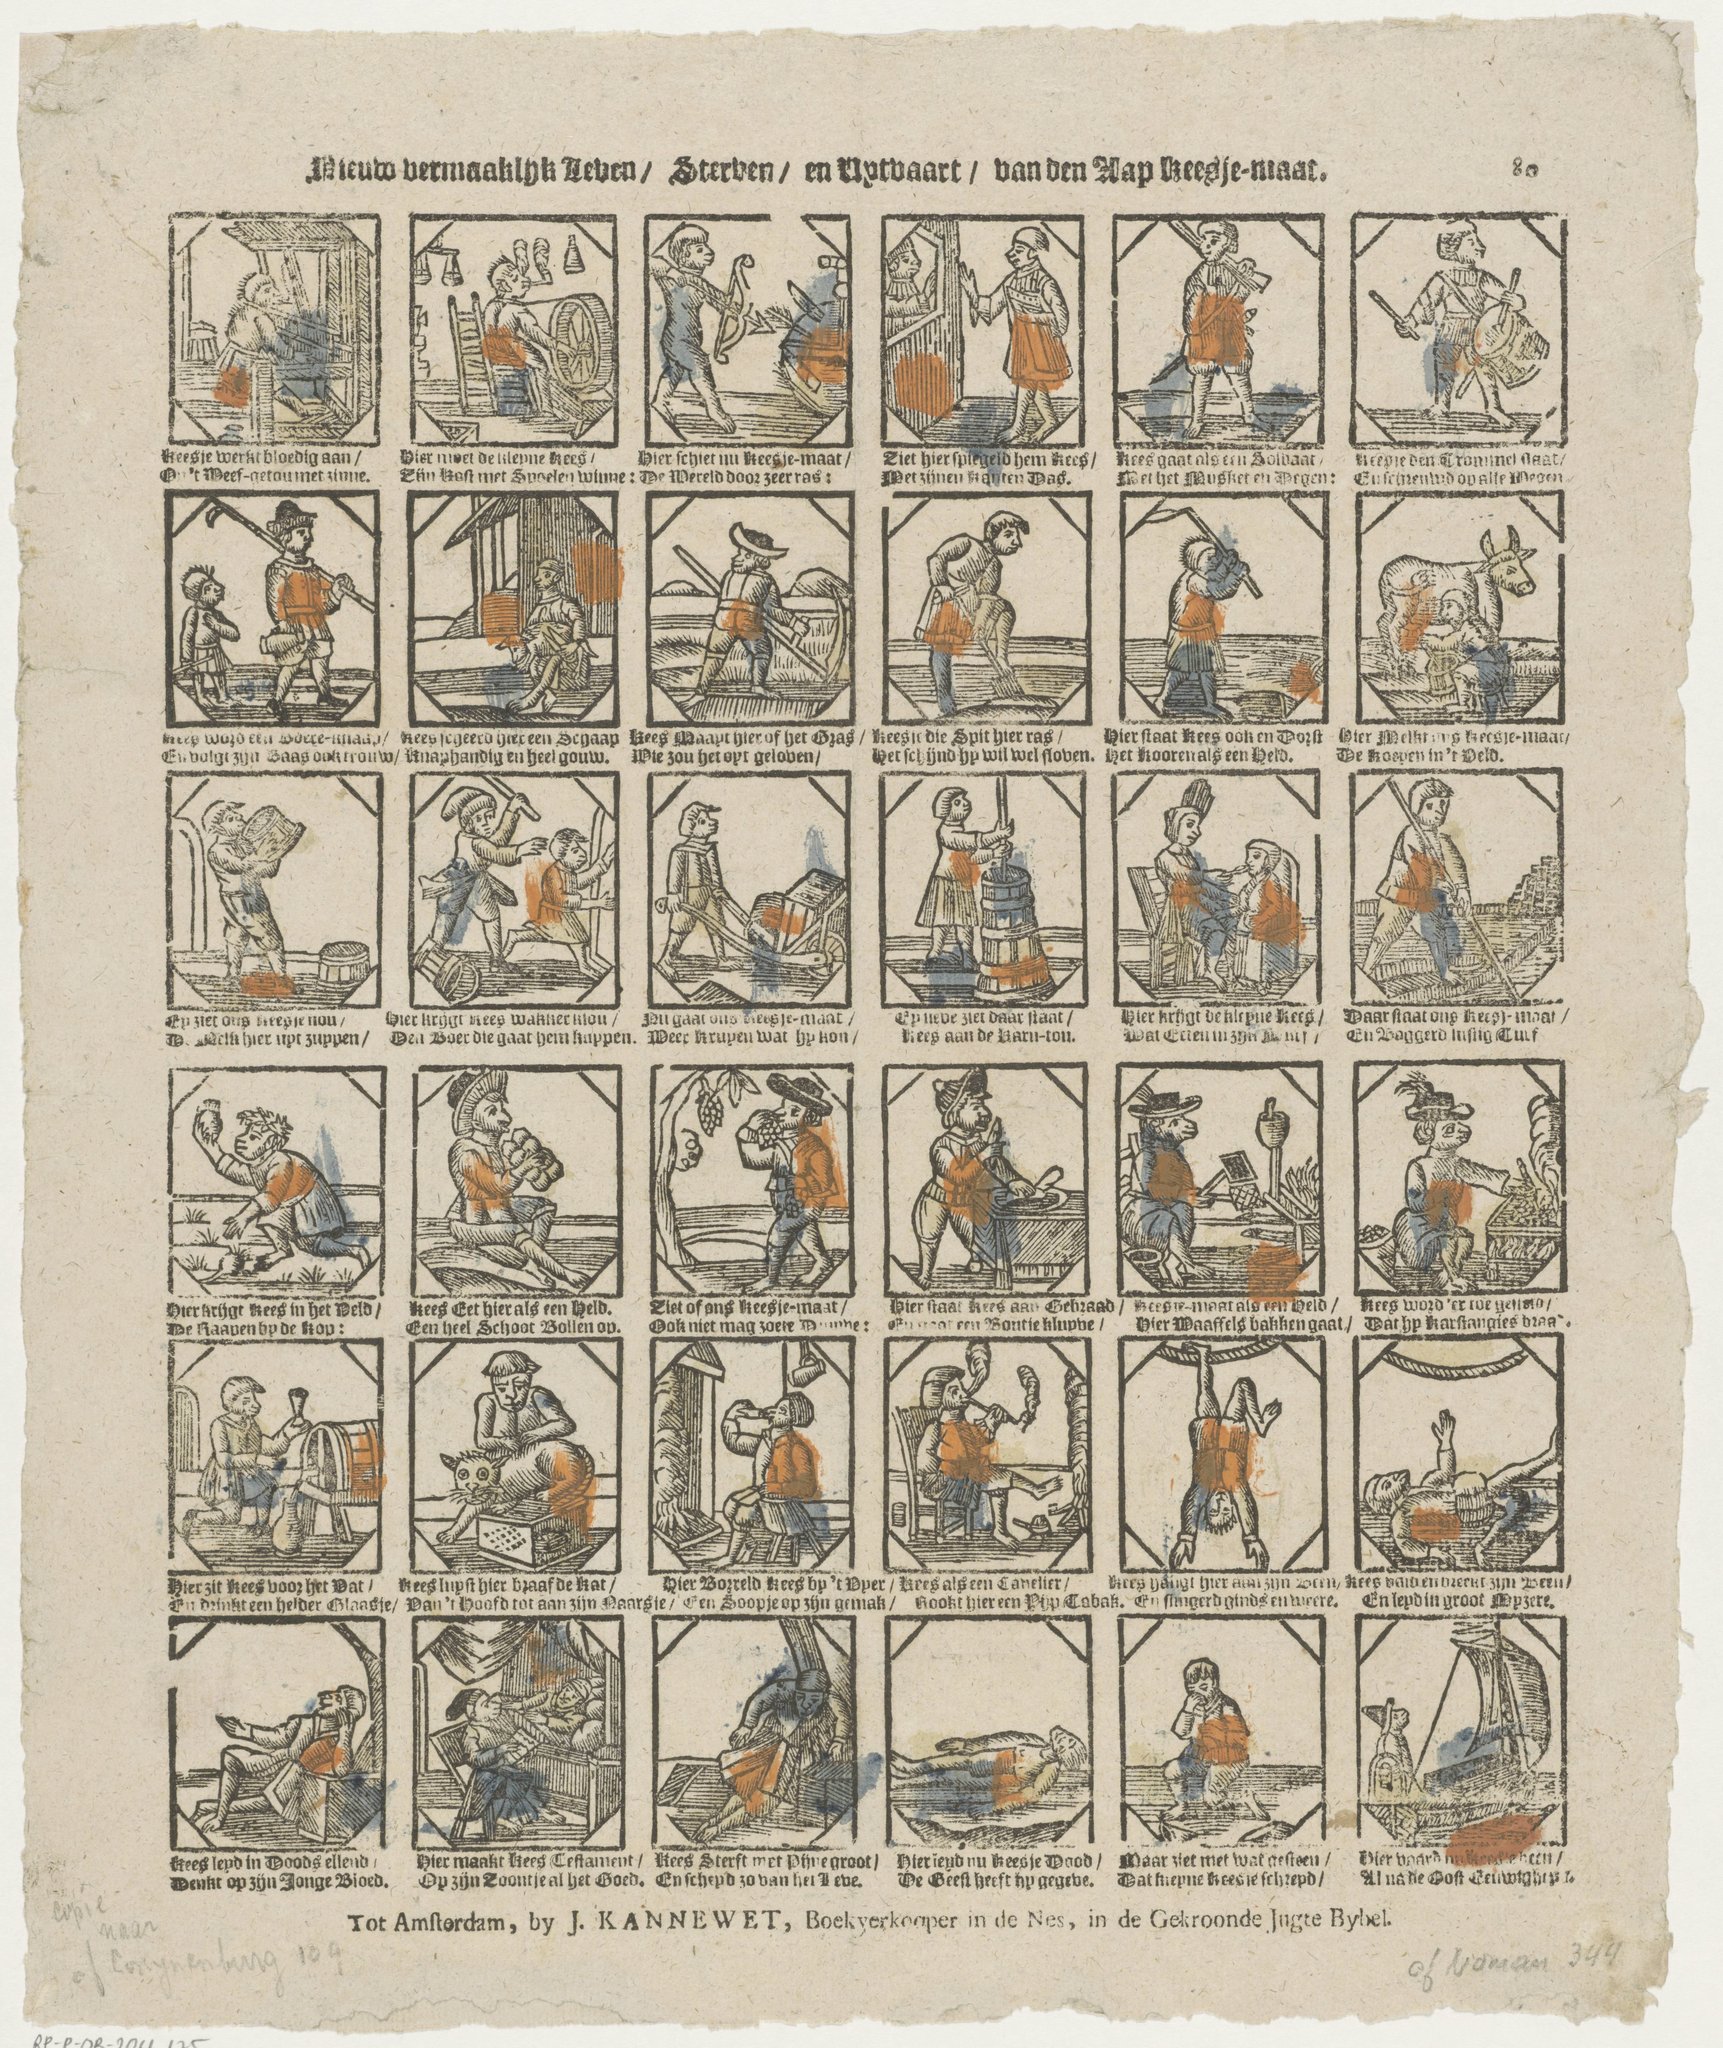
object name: print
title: Nieuw vermaaklijk leven / sterven / en uytvaart / van den aap Keesje-maat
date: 1725-1780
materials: paper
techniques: colour, letterpress printing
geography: amsterdam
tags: monkeys, apes, animals acting as human beings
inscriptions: collector's mark: Lugt 2228, collector's mark: Lugt 2760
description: Blad met 36 voorstellingen over het leven van de aap Kees, die zich als een mens gedraagt. Onder elke afbeelding een tweeregelig vers. Genummerd rechtsboven: 80.